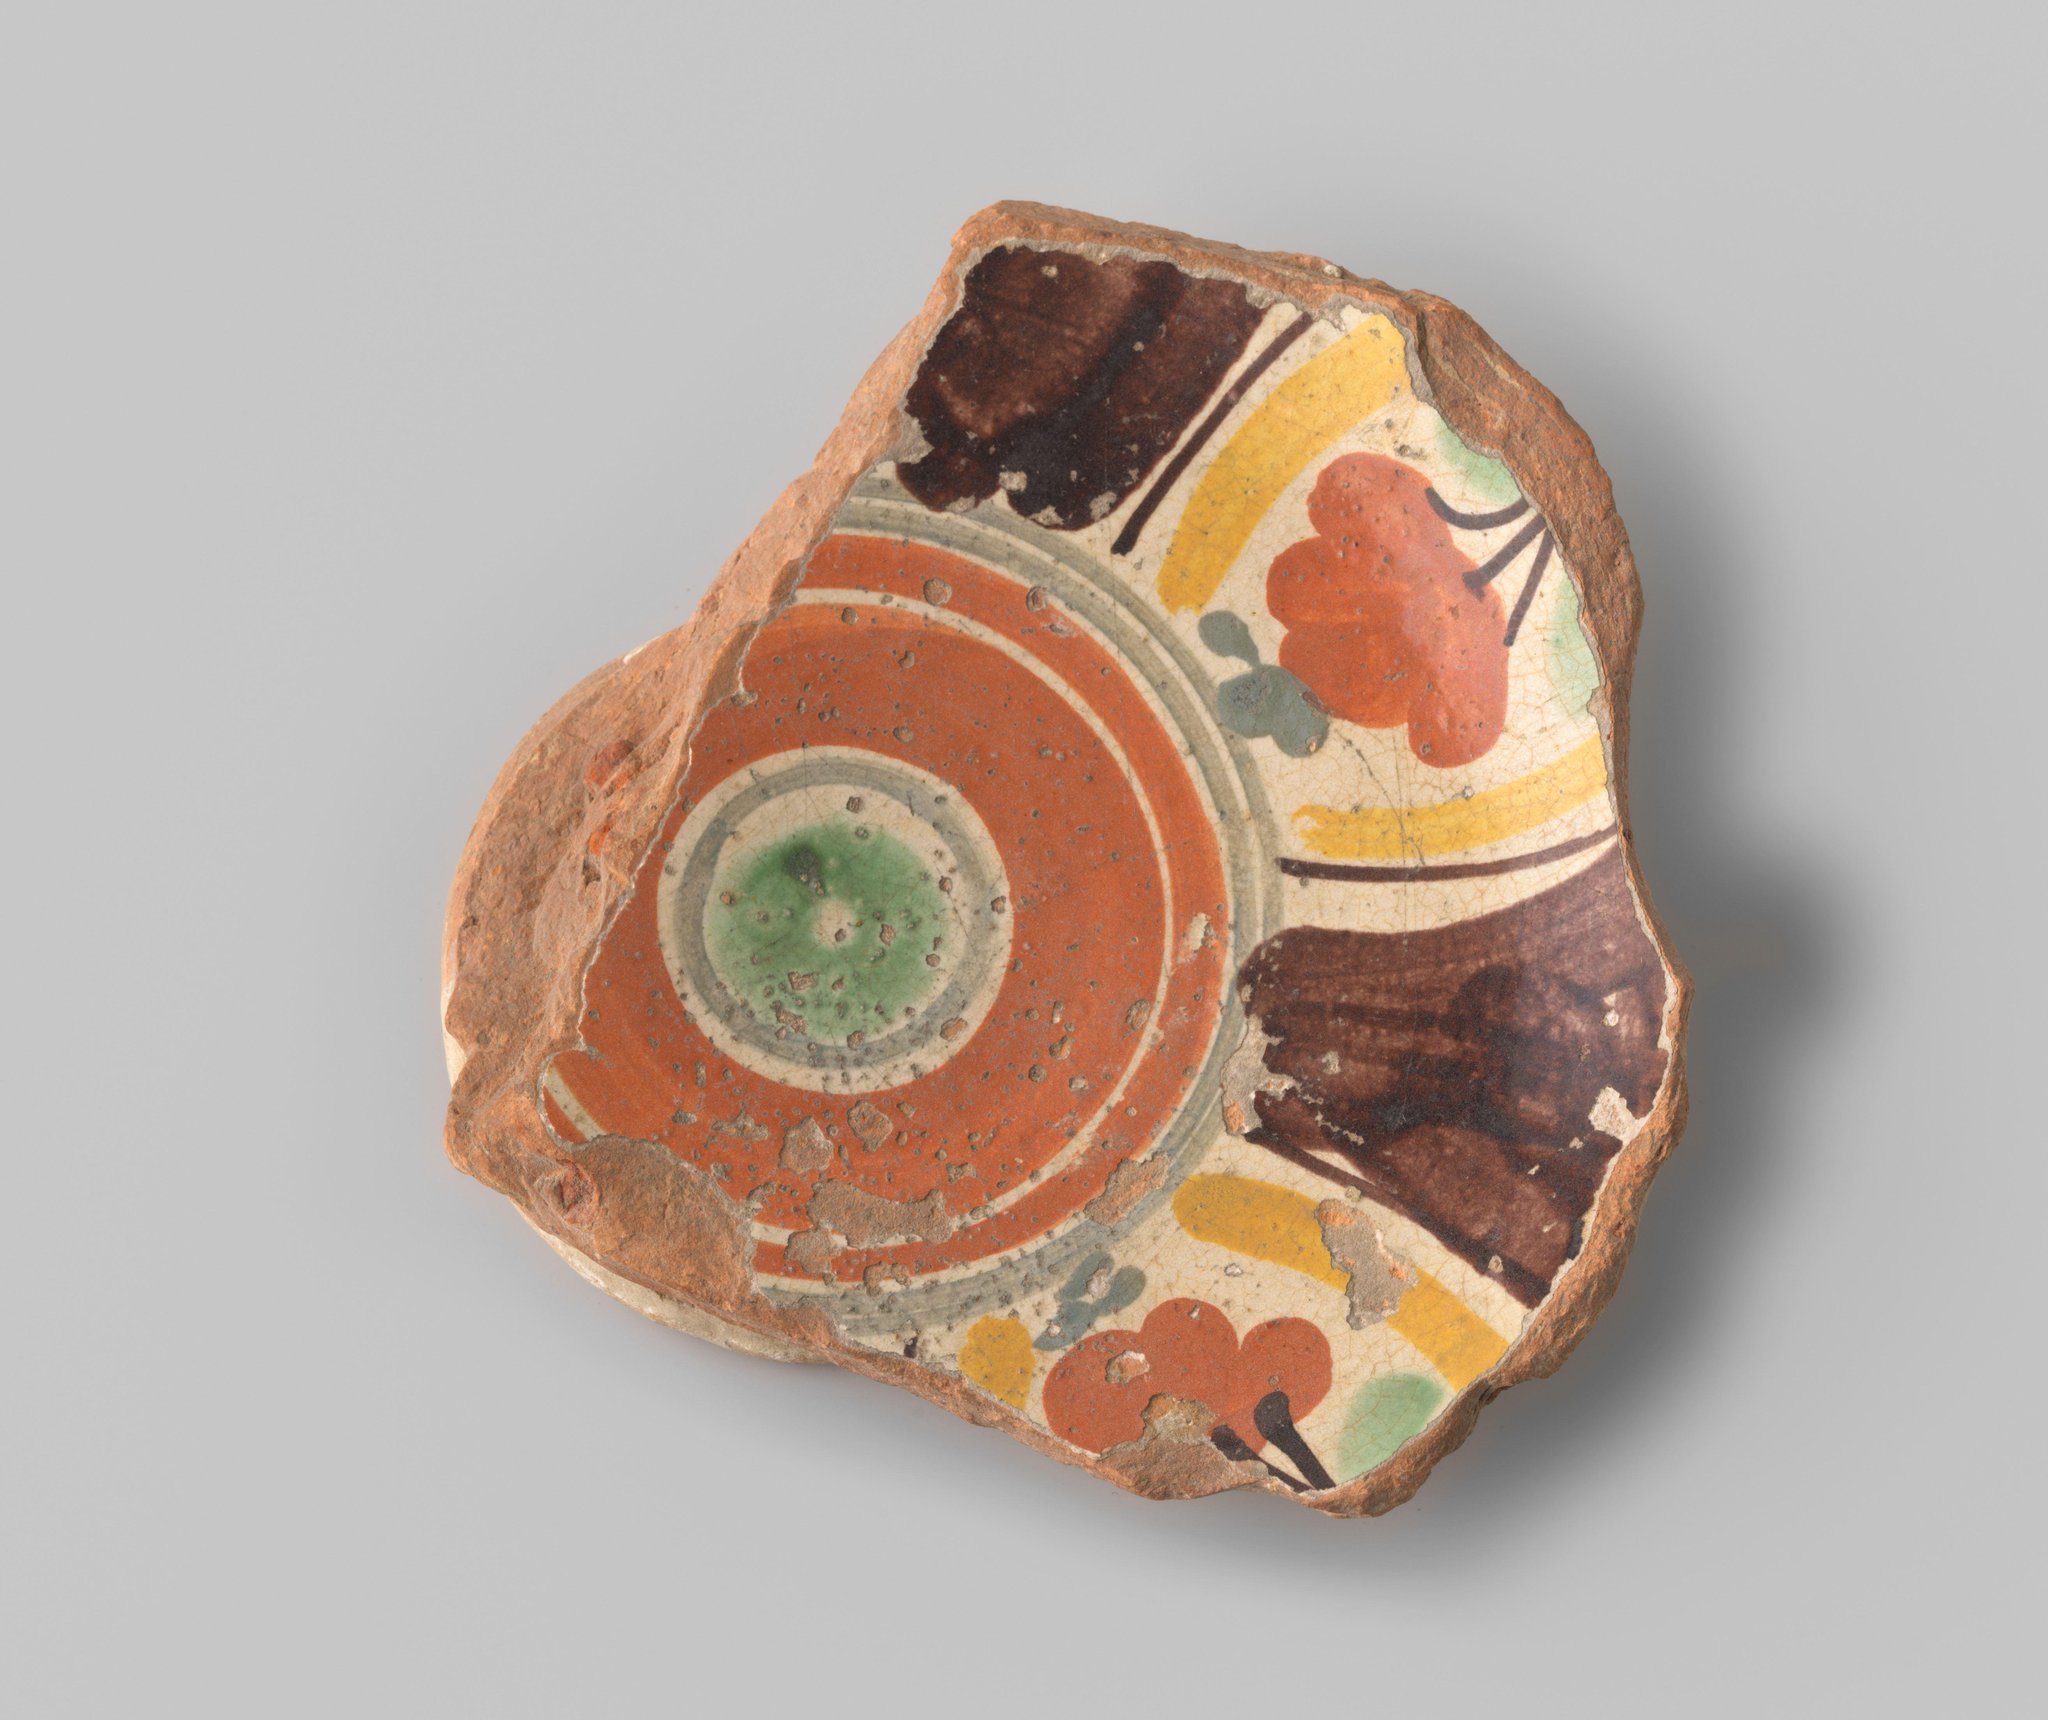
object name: sherd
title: Fragment (voet) met rode scherf, aan de bovenzijde voorzien van rood, geel, wit, bruin, groen en blauw glazuur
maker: Anonymous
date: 1200-1899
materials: earthenware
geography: italy